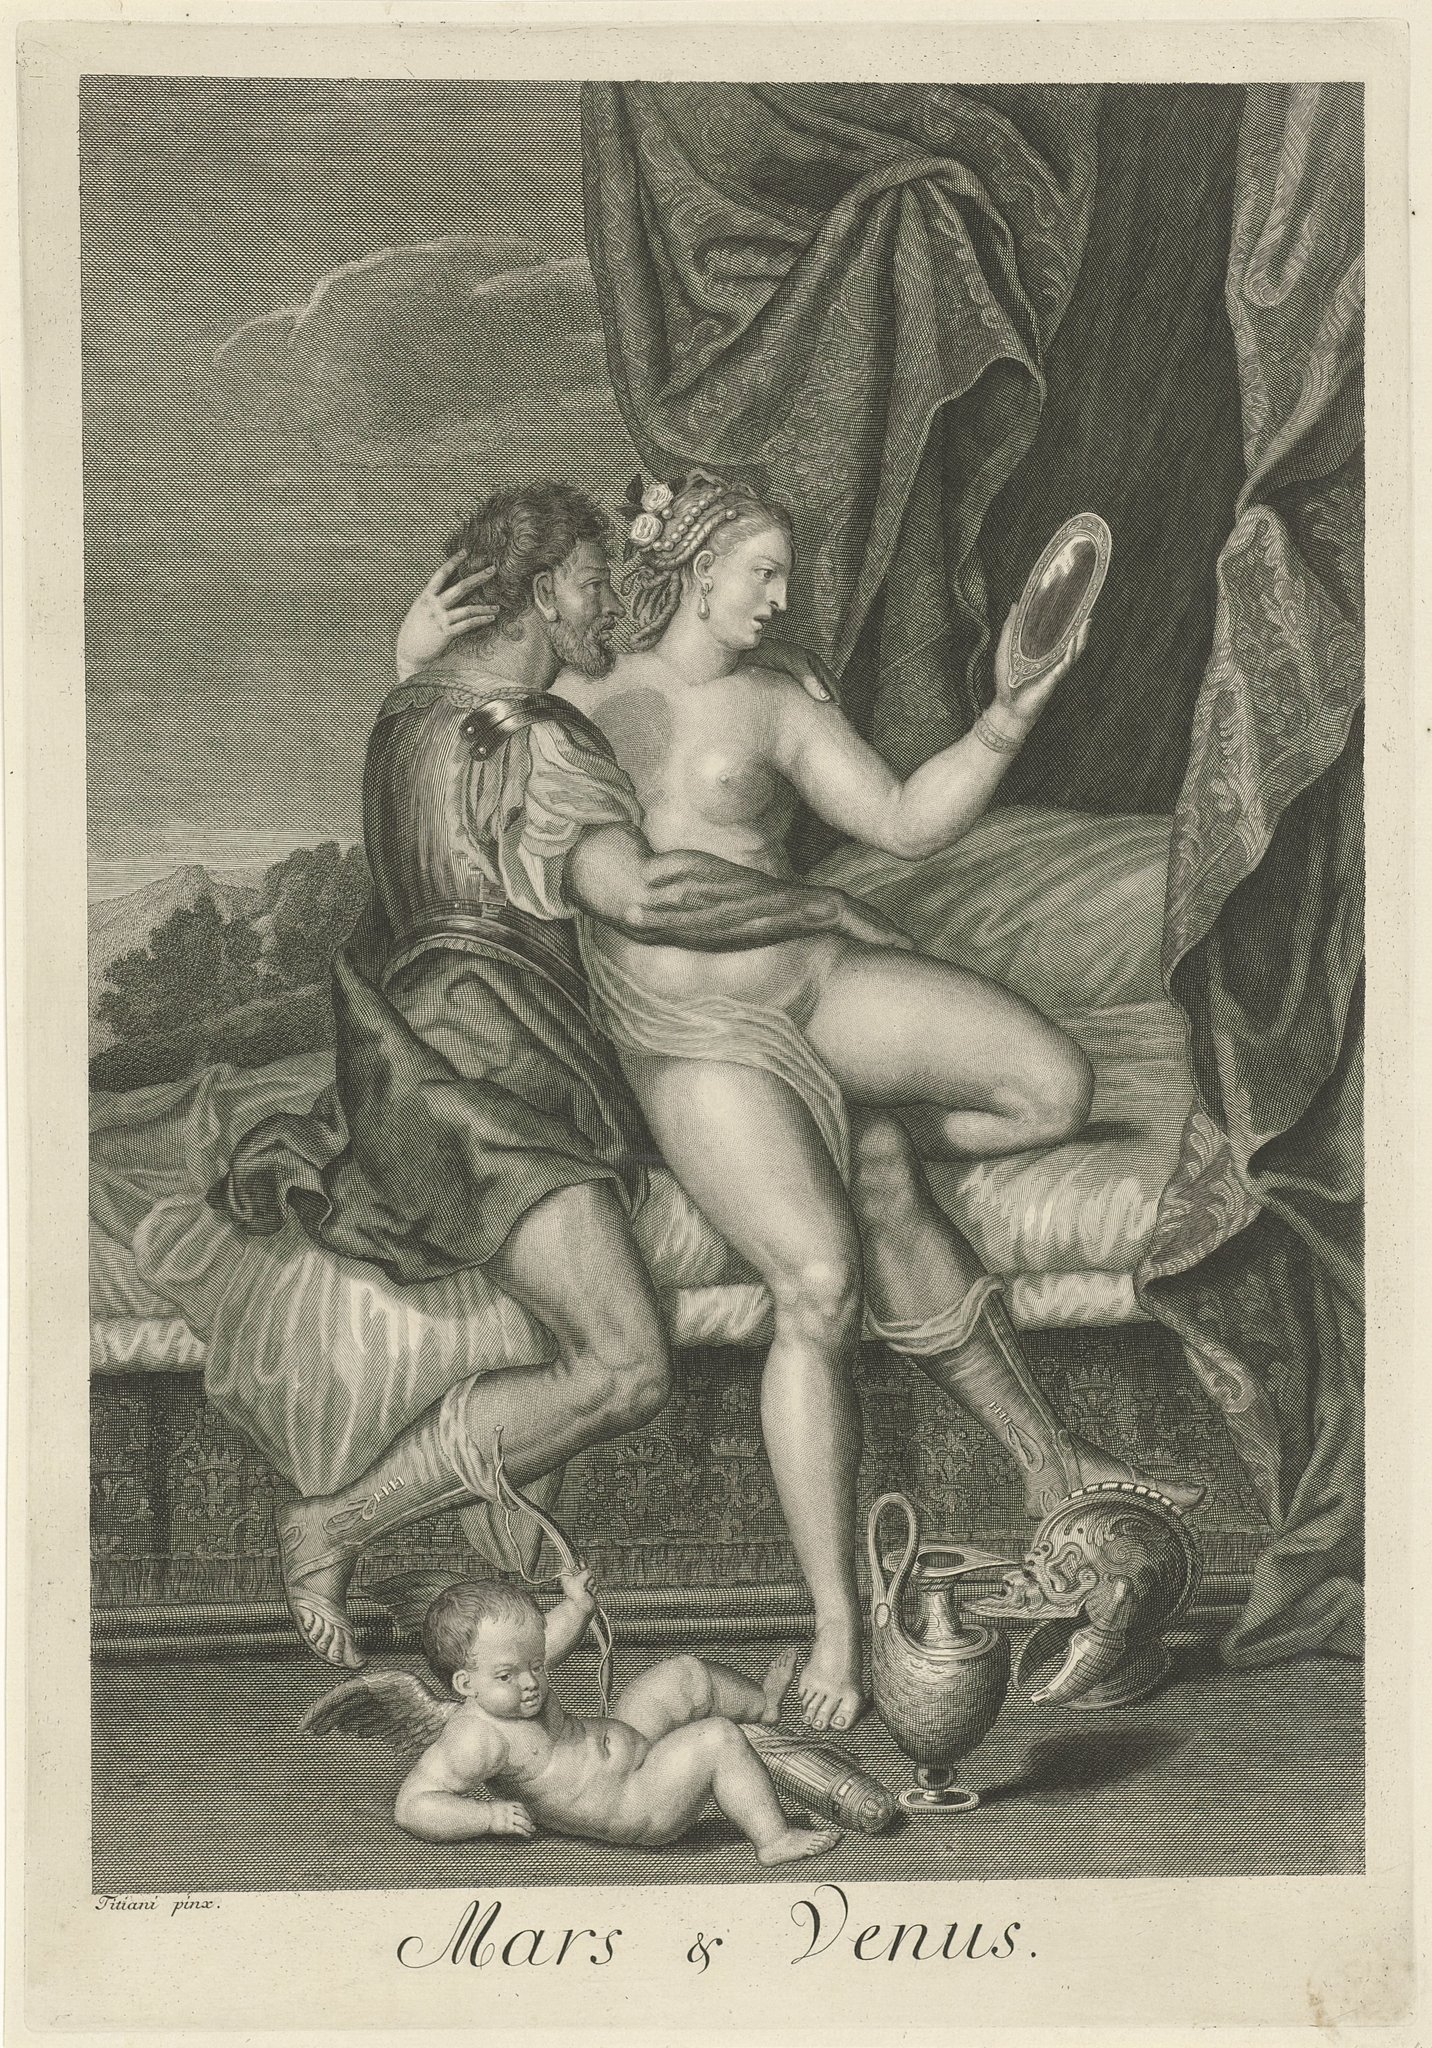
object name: print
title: Mythologische liefdesverhalen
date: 1659-1731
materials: paper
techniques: engraving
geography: amsterdam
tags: toilet of venus, (story of) cupid, amor (eros)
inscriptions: collector's mark: Lugt 240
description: Mars en de naakte Venus zitten samen op bed. Venus kijkt in een spiegel. Cupido ligt op de voorgrond.